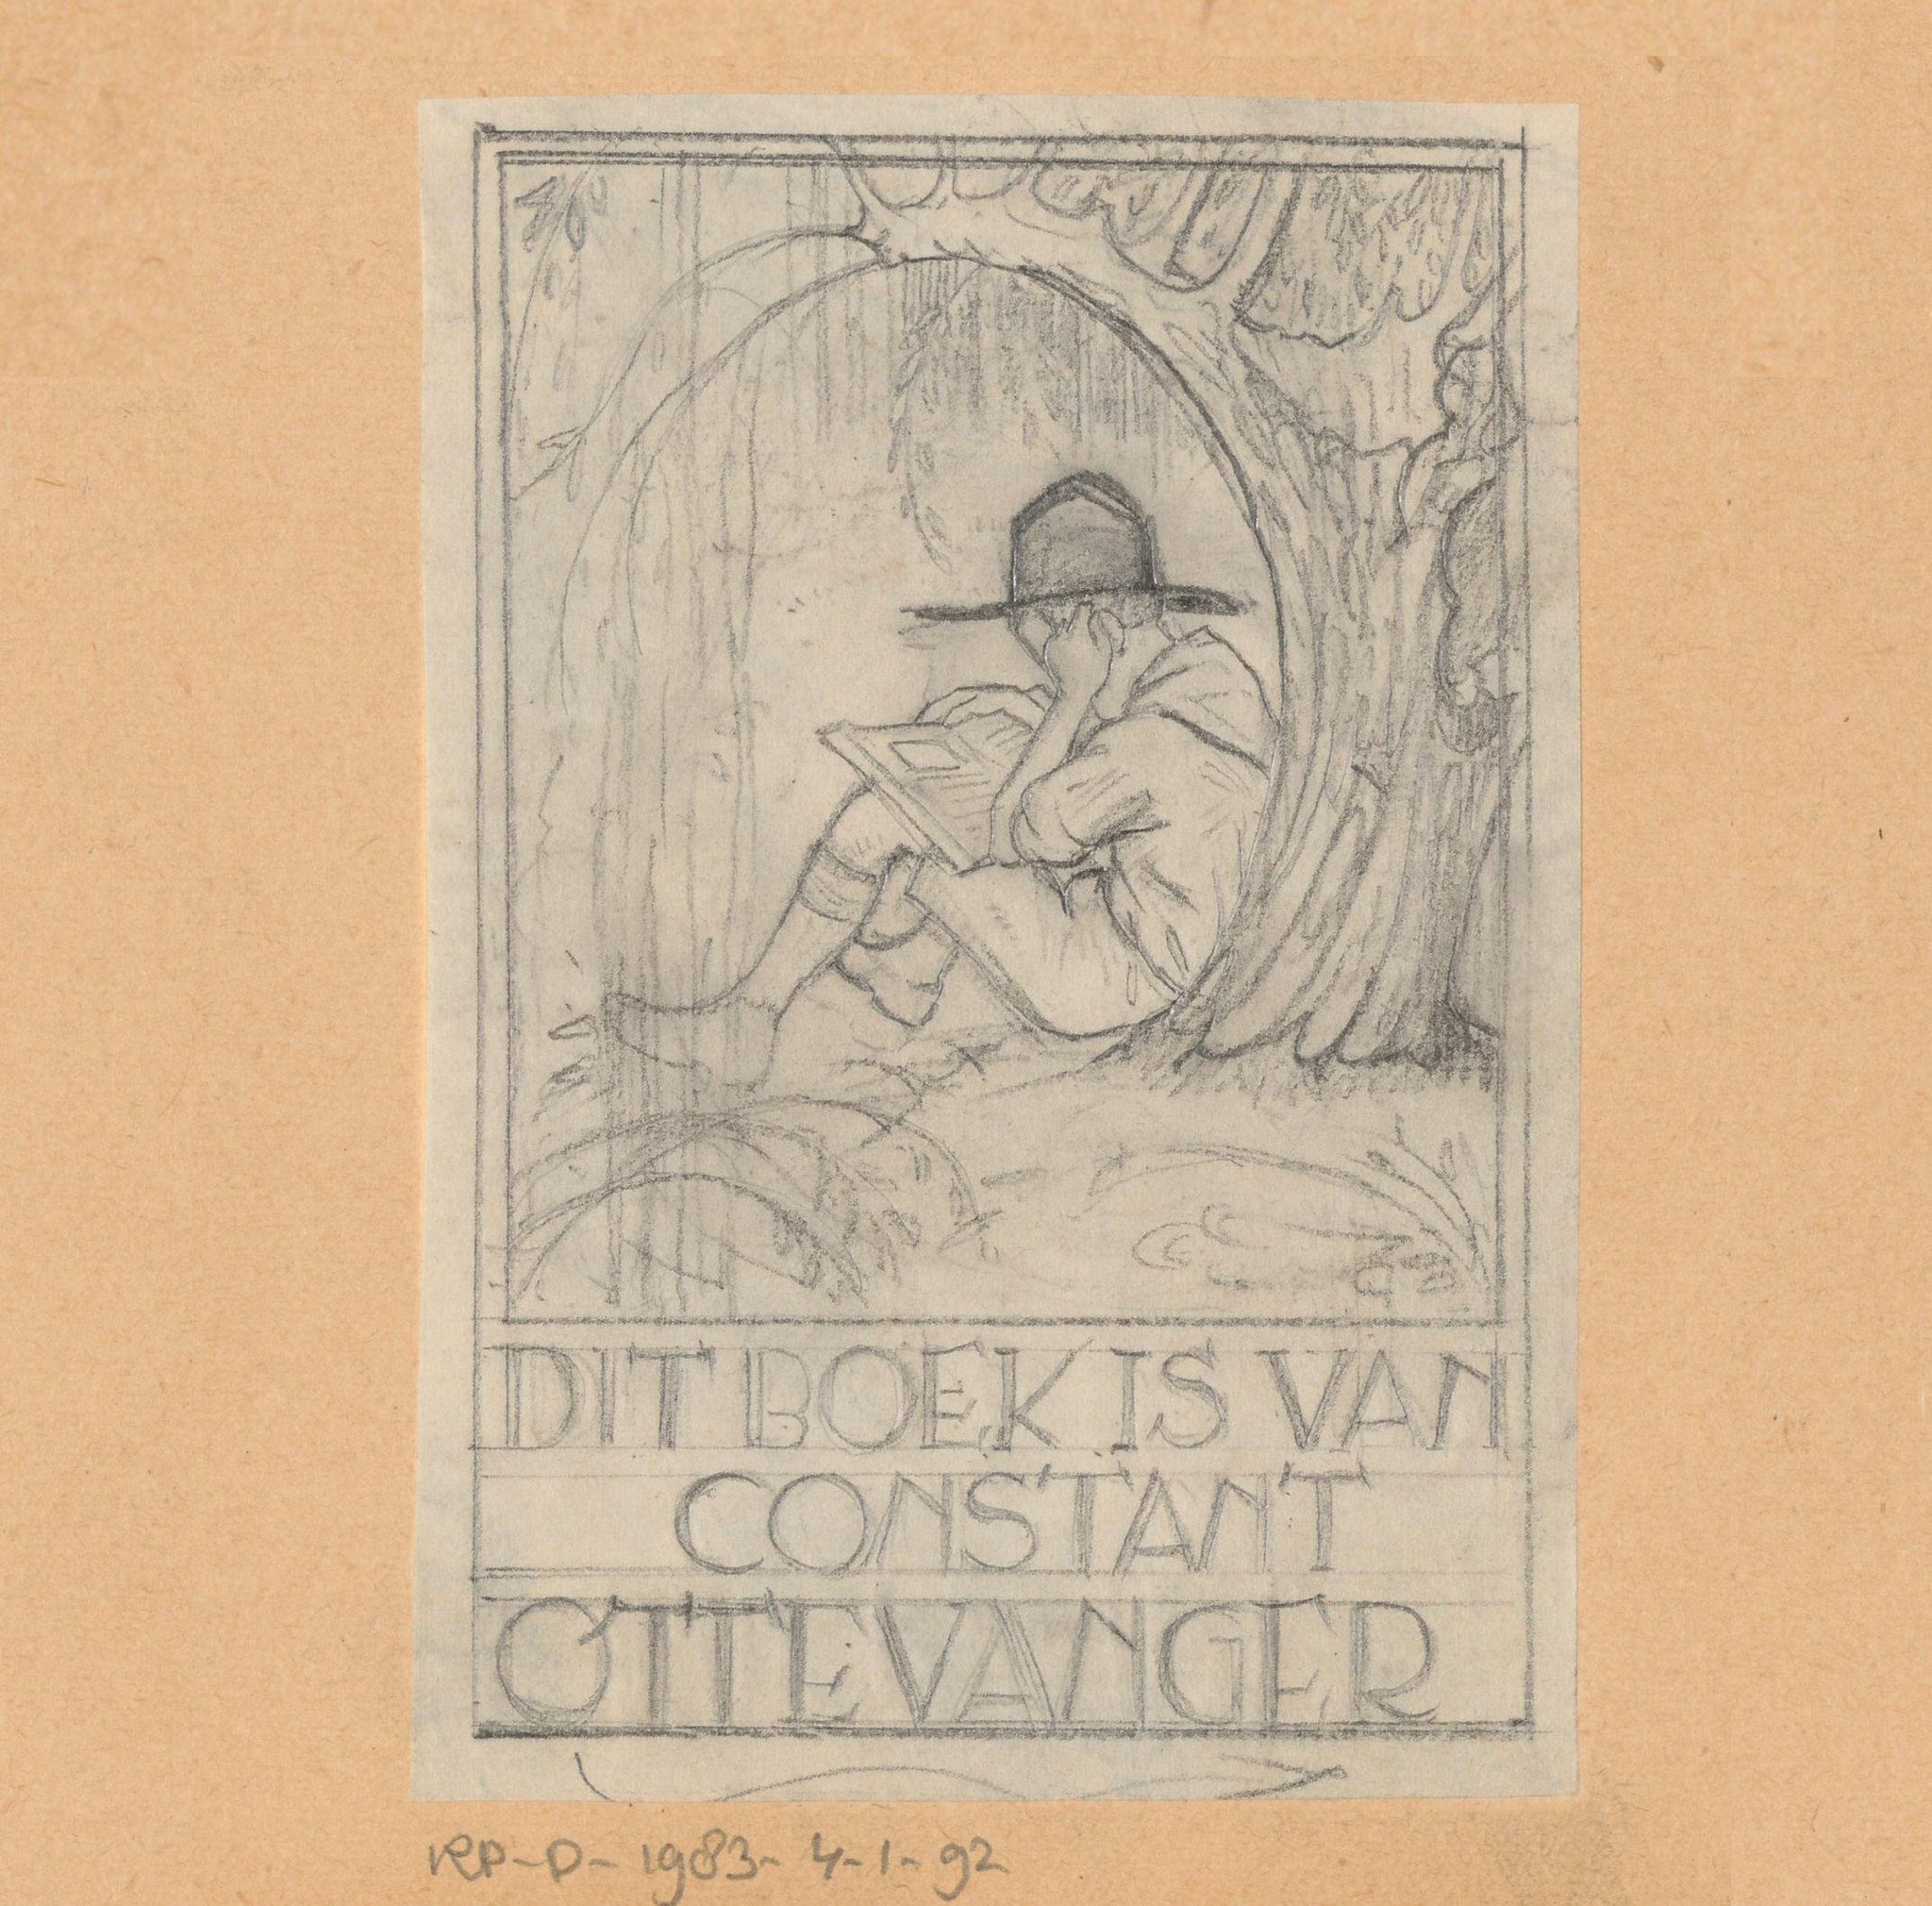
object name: design drawing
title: Ontwerptekening voor ex libris van Constant Ottevanger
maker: otto verhagen (i)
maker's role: draughtsman, print maker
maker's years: 1885-1951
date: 1933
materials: paper, pencil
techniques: drawing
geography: netherlands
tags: trees, sitting figure, reading, boy (child between toddler and youth), head-gear: hat, book